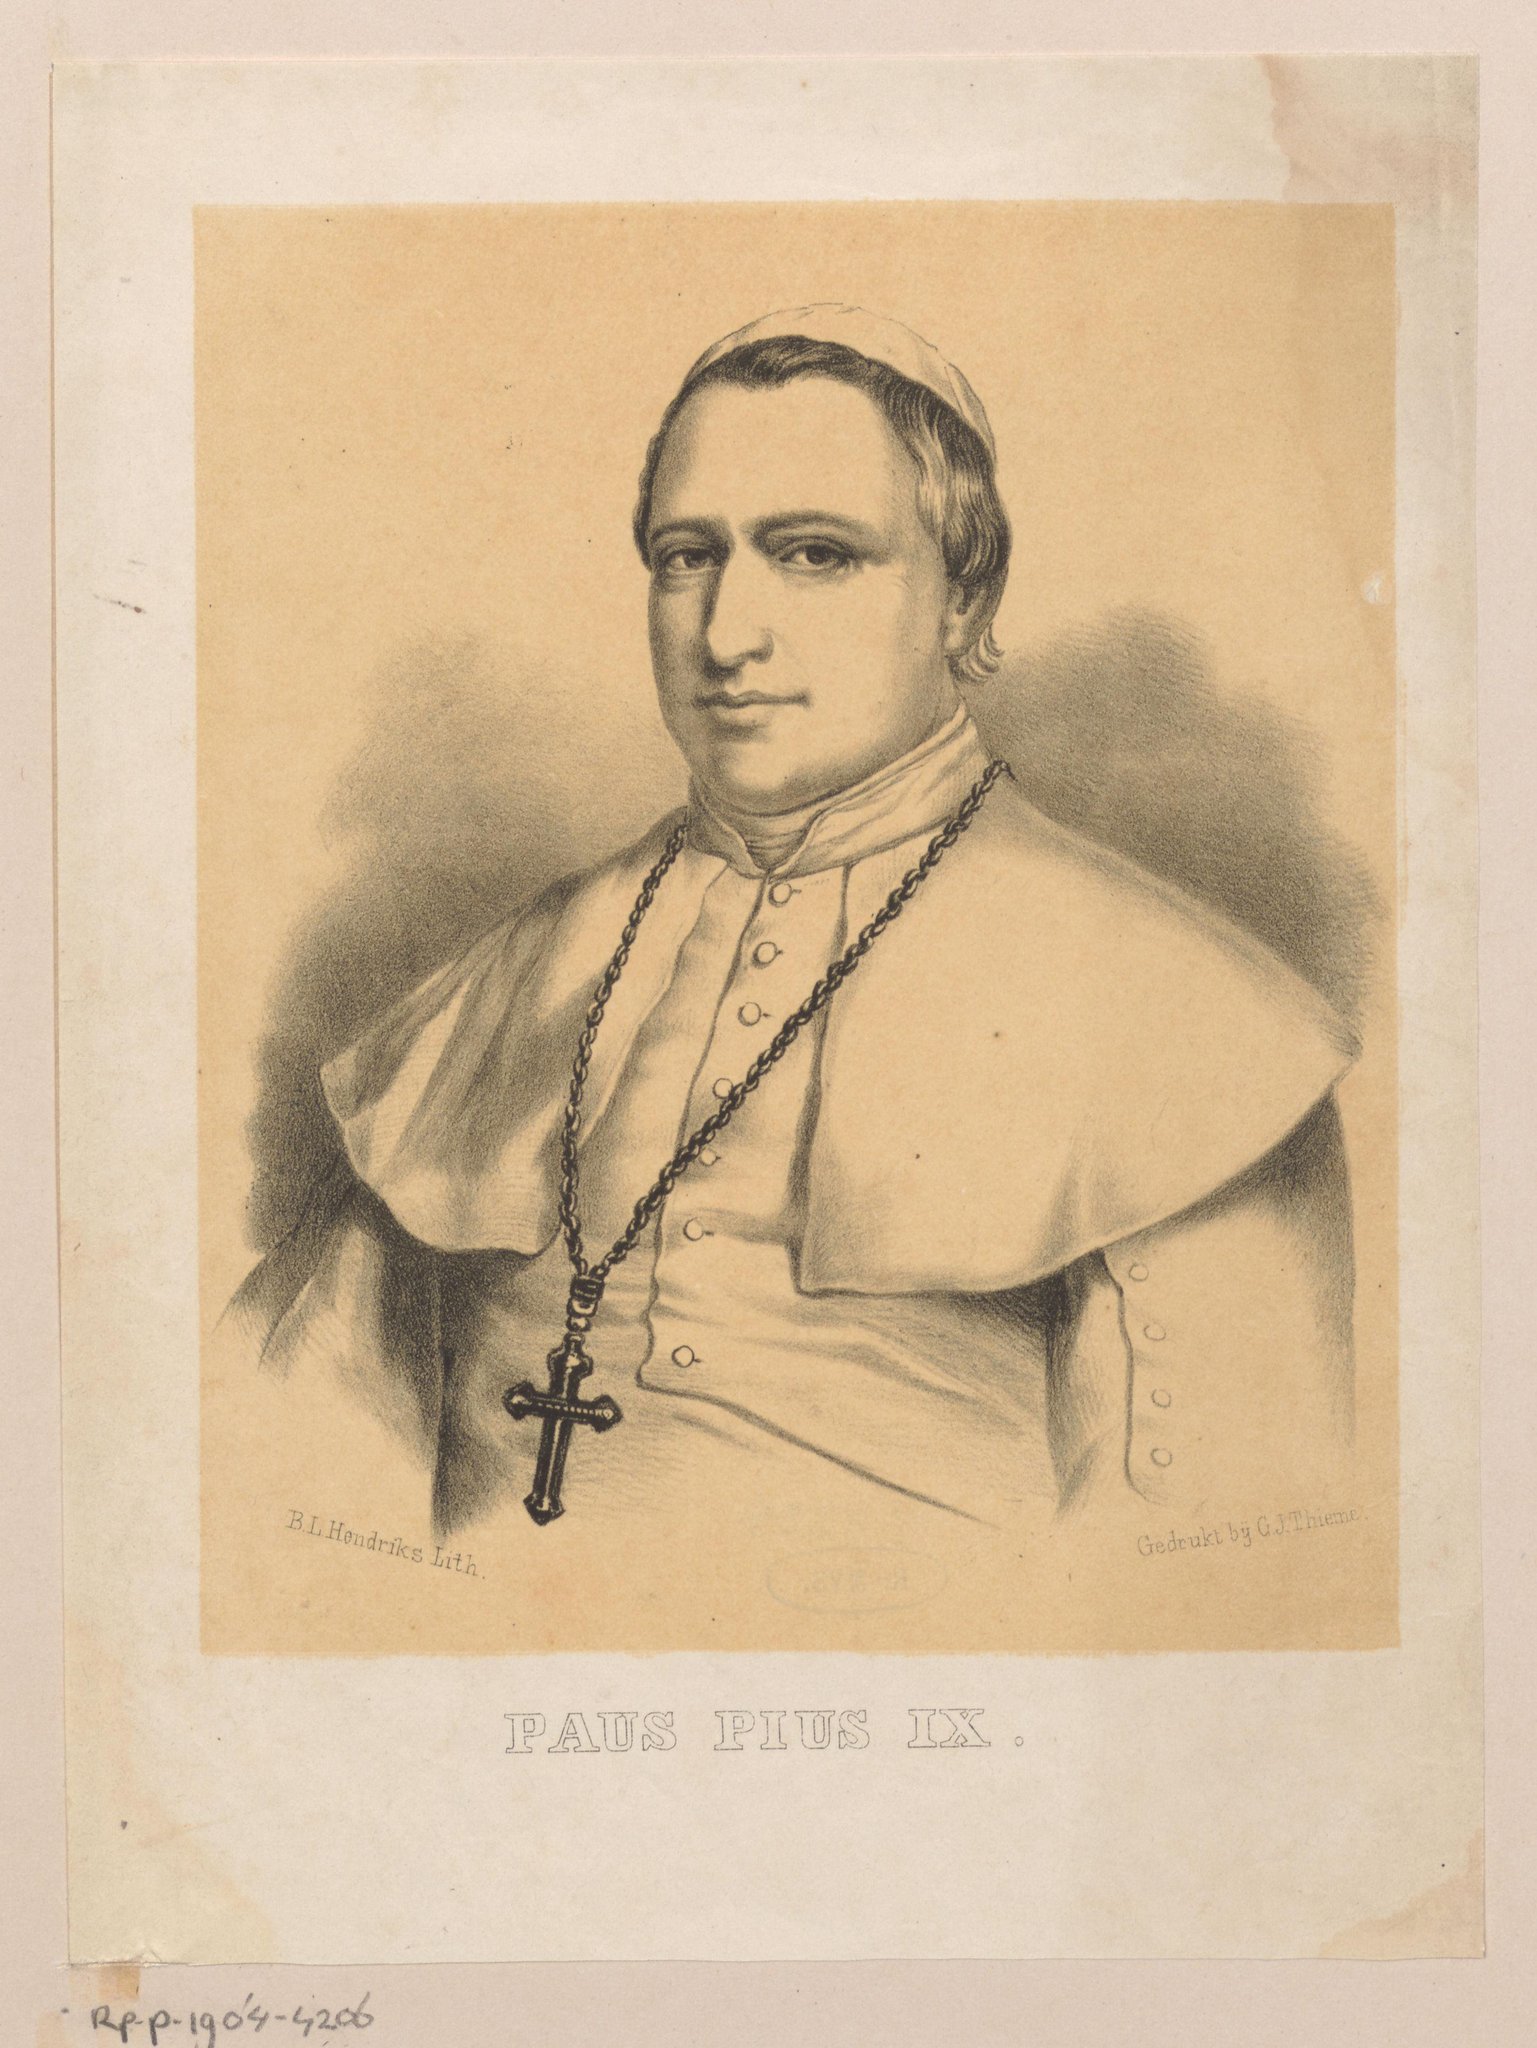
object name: print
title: Portret van paus Pius IX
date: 1846-1899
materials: paper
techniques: tone lithography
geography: arnhem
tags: rome, historical persons, pope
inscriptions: collector's mark: Lugt 2228